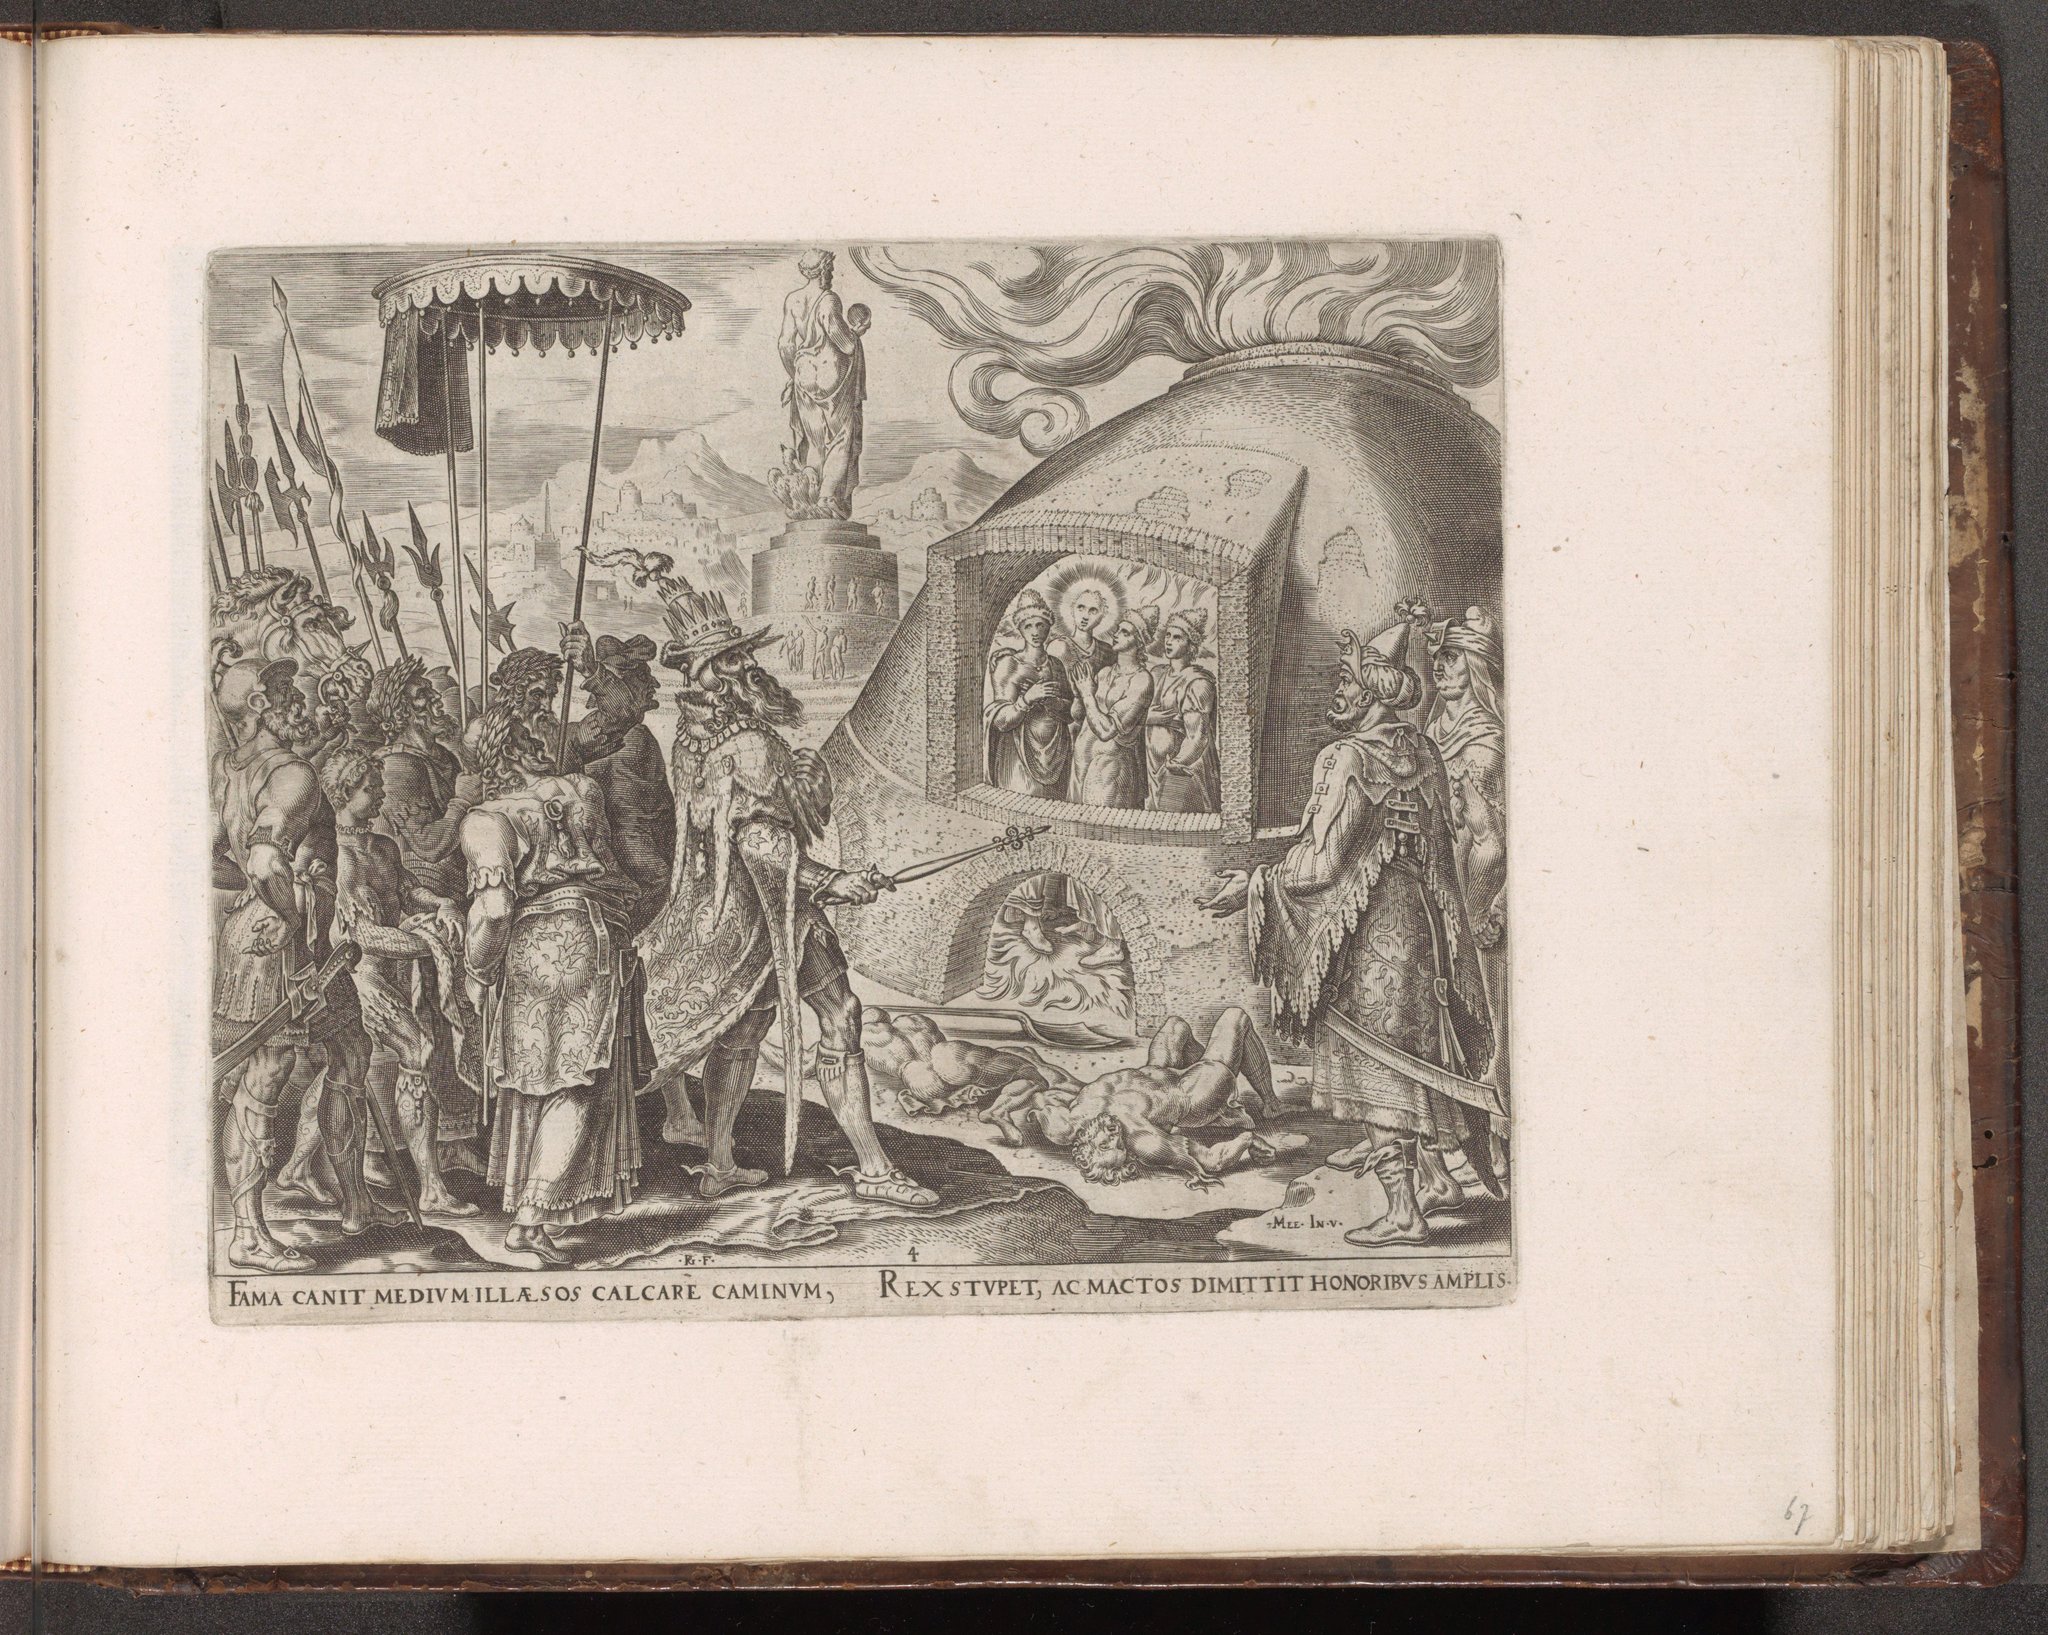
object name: album leaf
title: Geschiedenis van Sadrach, Mesach en Abednego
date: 1565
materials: paper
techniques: engraving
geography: antwerp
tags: to his astonishment king nebuchadnezzar sees four men (one of them usually represented as an angel) in the furnace; the king commands them to come forth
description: Nebukadnessar komt kijken bij de oven en ziet met verbazing dat Sadrach, Mesach en Abednego ongedeerd blijven. Ook ziet hij tussen hen een vierde man staan met een aureool. Op de grond voor de oven liggen de verbrandde bewakers. Onder de voorstelling een verklarende tekst in het Latijn. Prent maakt deel uit van een album.